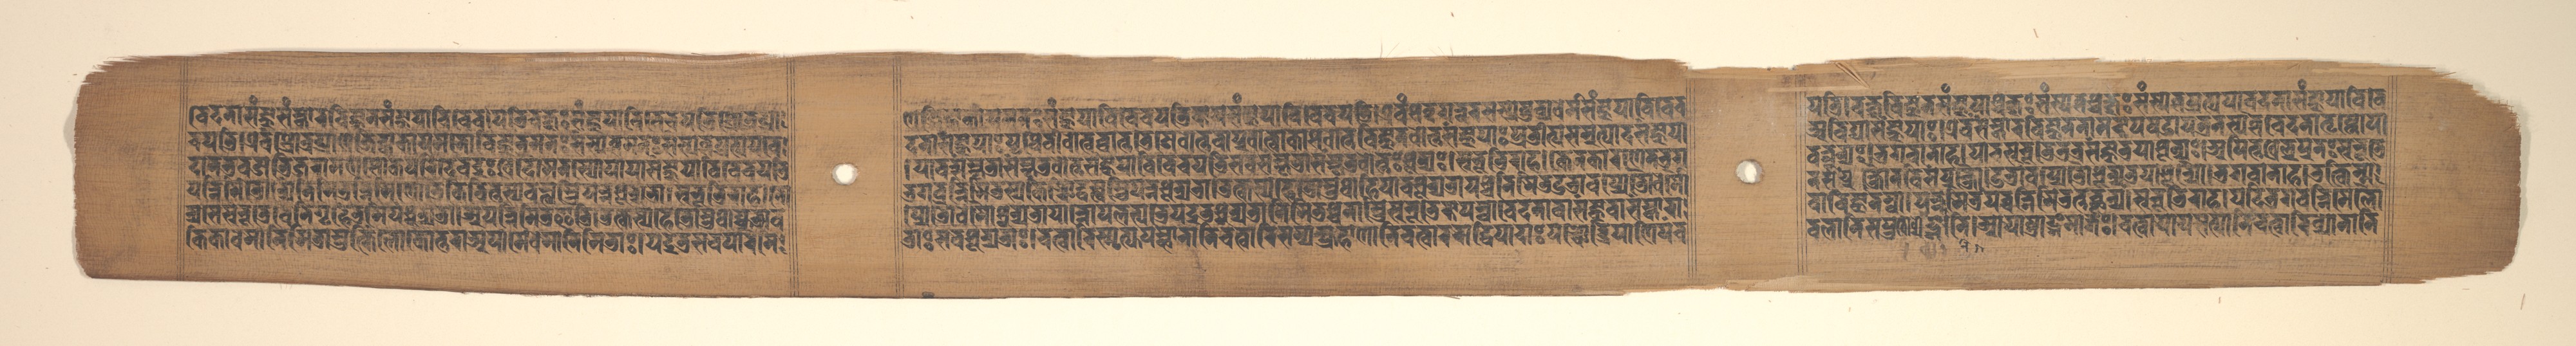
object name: folio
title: Folio from a Buddhist Manuscript of Pancavimsatisahasrika Prajnaparamita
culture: indian, bengal or bangladesh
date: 1090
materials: leaf, watercolor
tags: buddhism